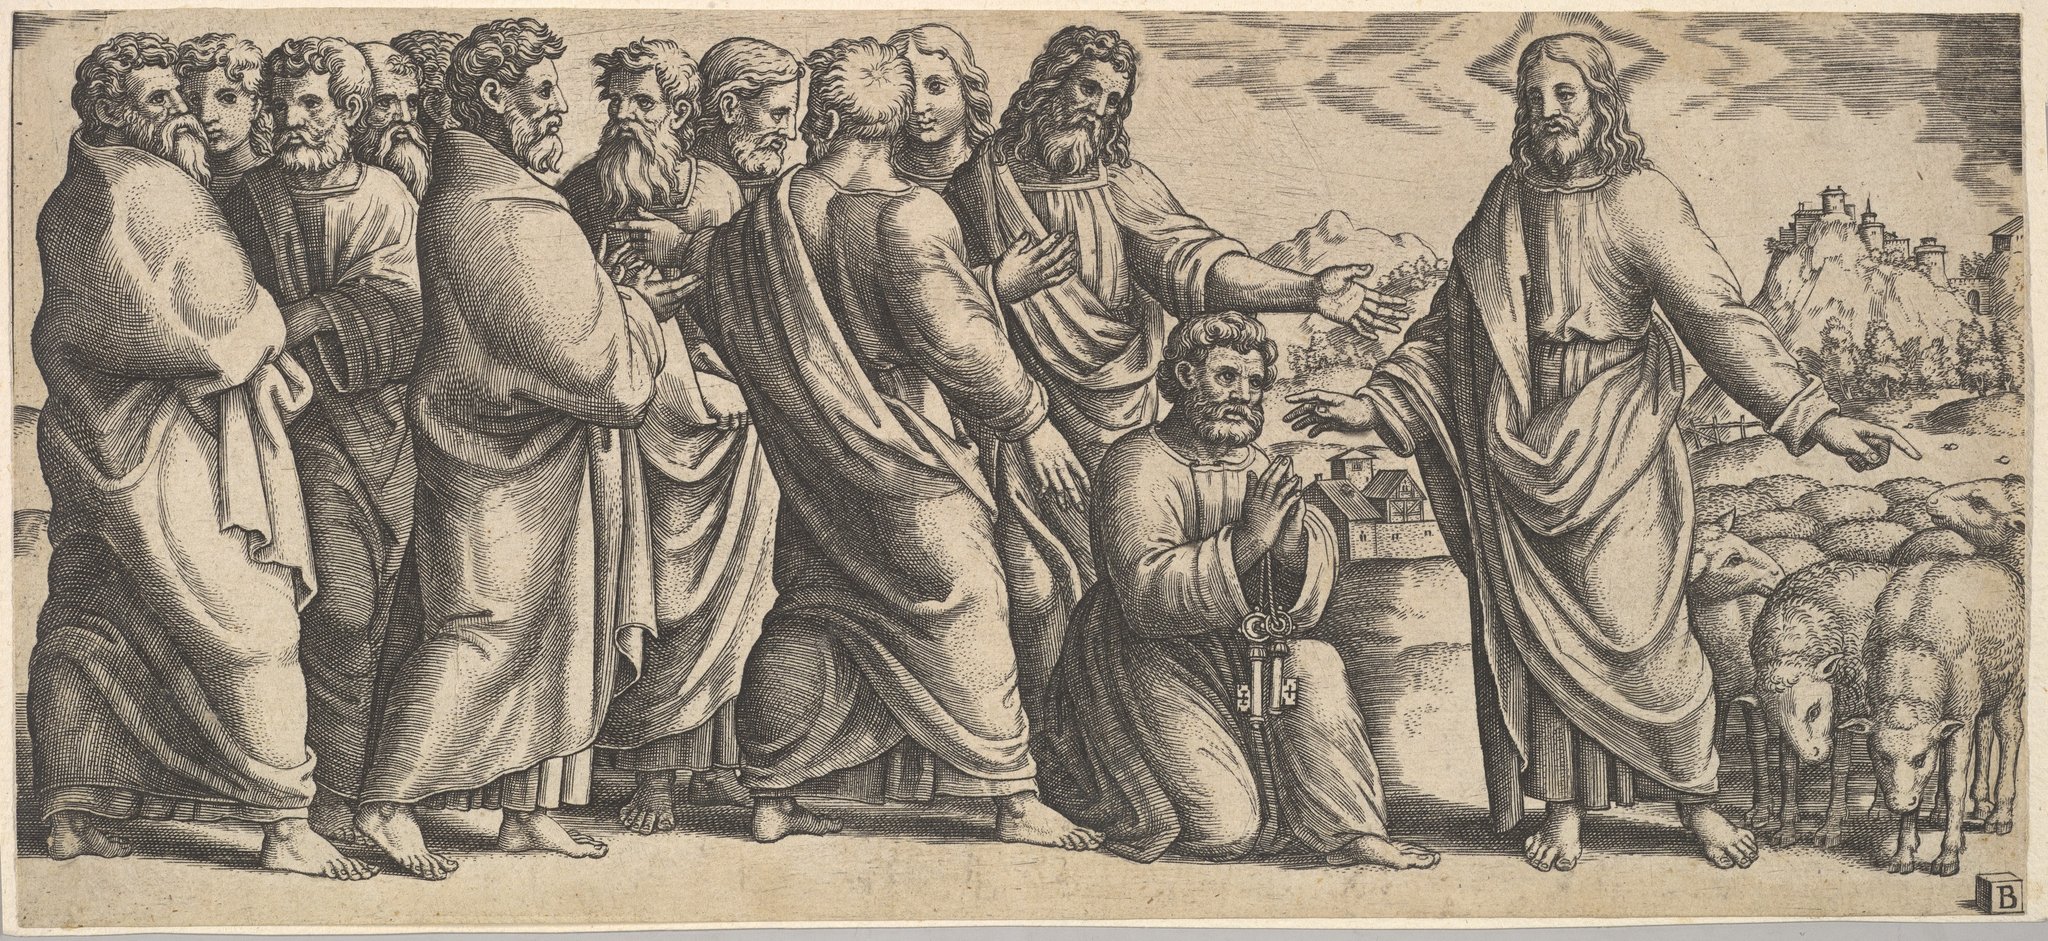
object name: print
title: The Delivery of the Keys to Peter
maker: master of the die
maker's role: artist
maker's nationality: italian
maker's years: 1525-1560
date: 1520-1570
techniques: engraving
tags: sheep,christ,saint peter,keys